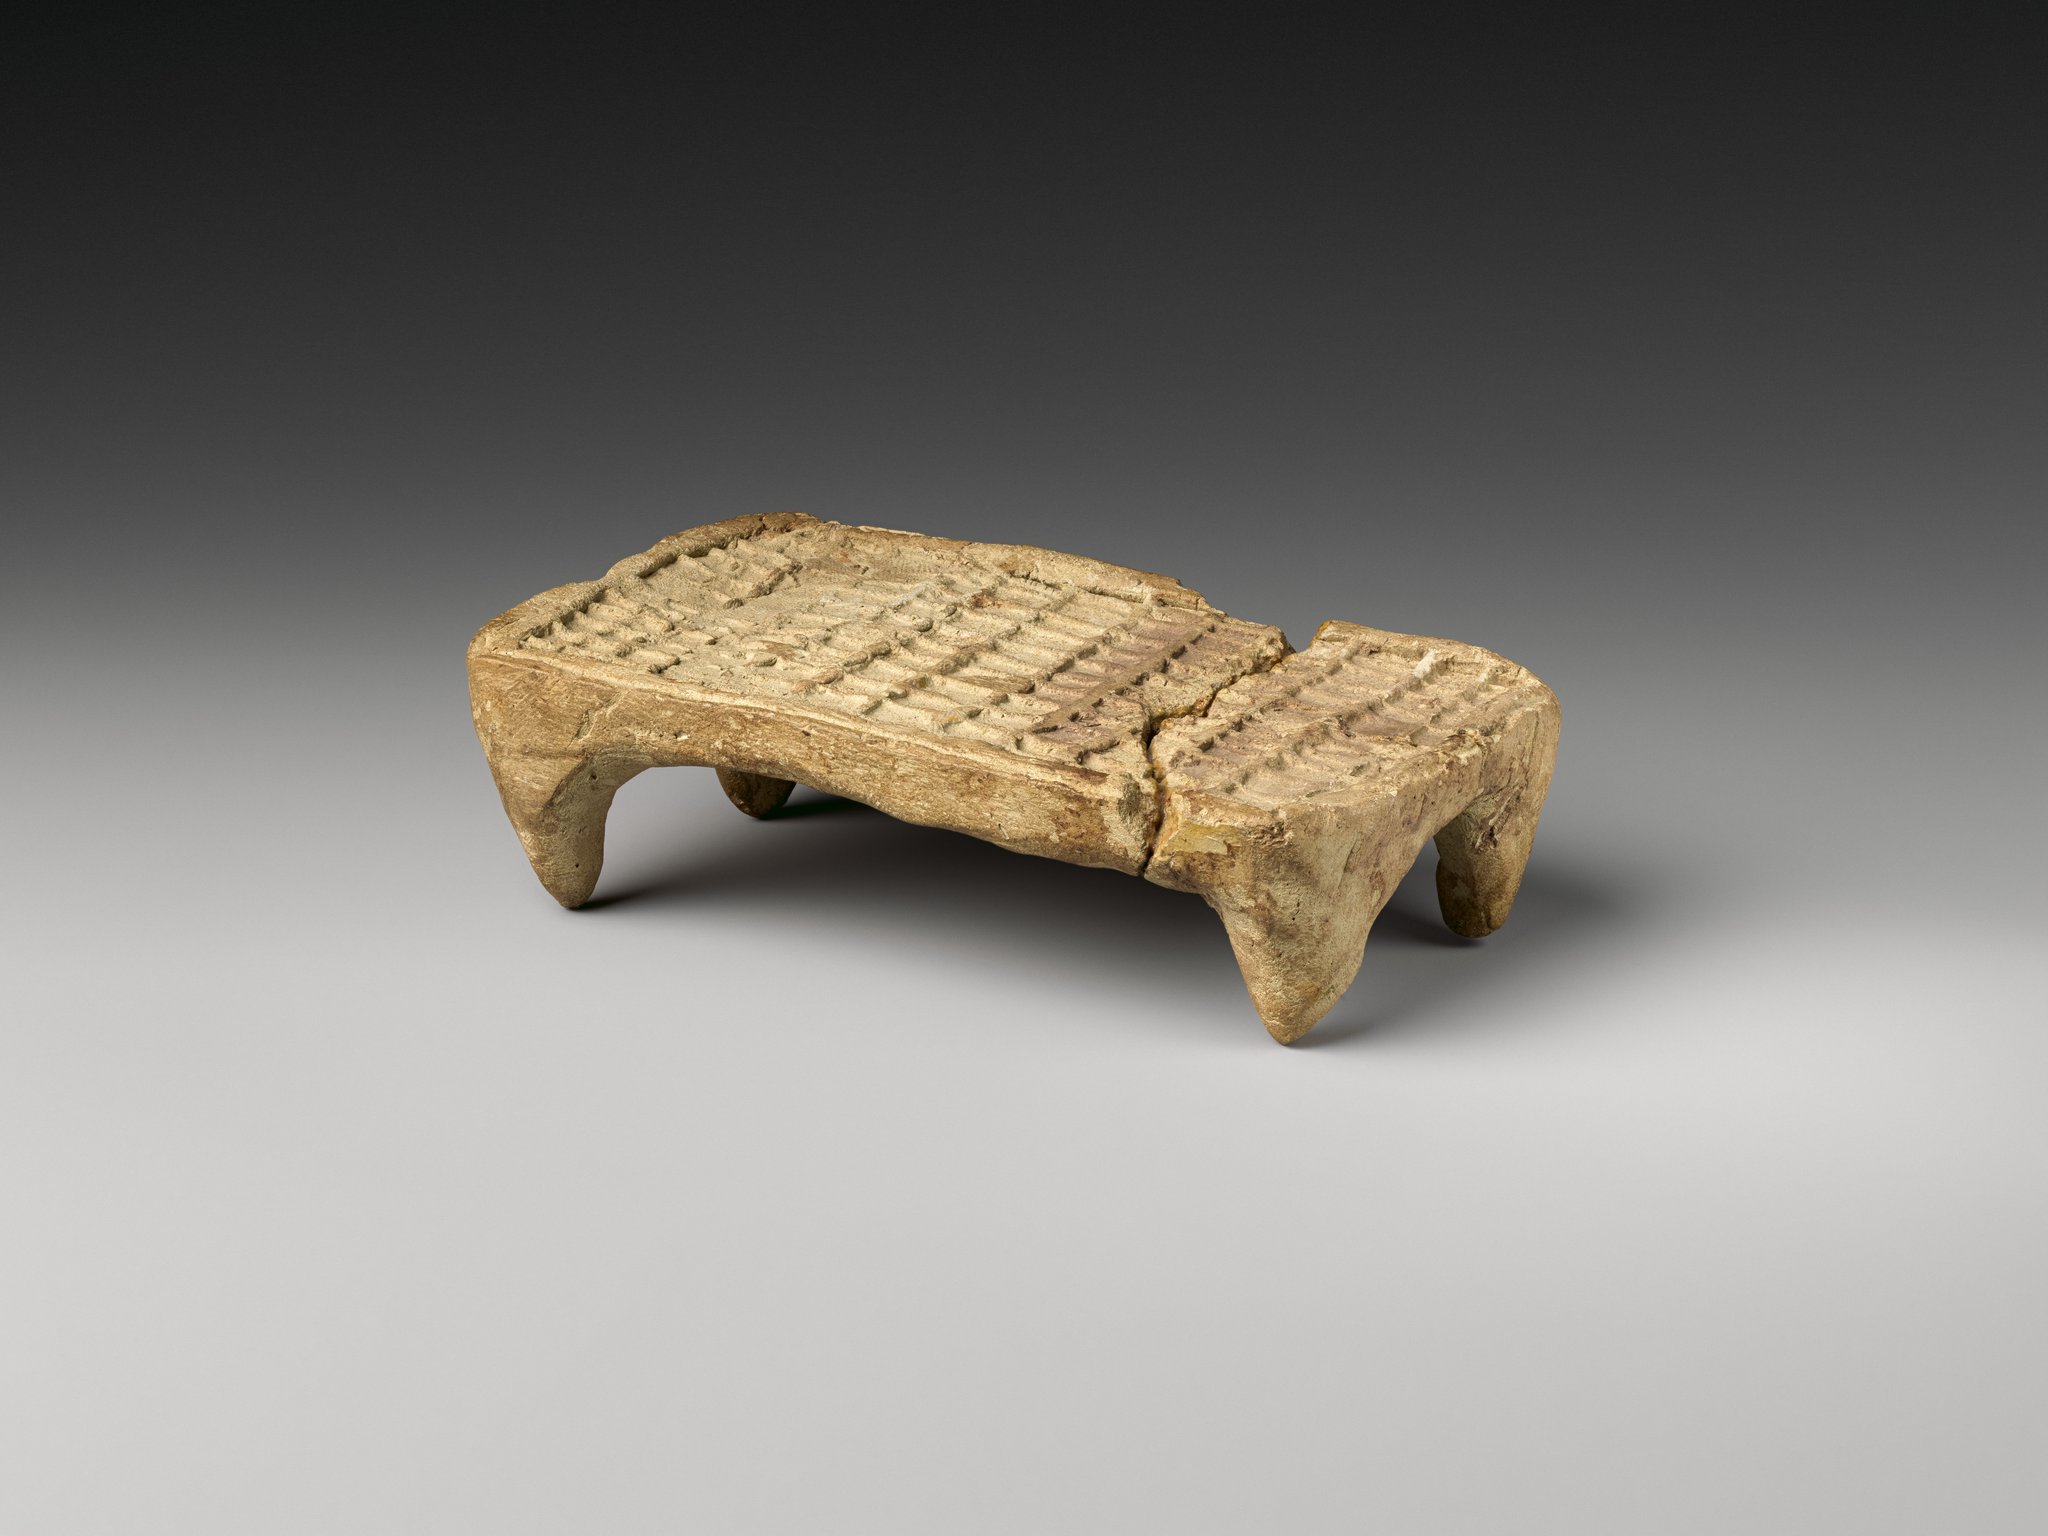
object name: bed model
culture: isin-larsa–old babylonian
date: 1900-1600 BCE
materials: ceramic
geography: mesopotamia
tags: beds